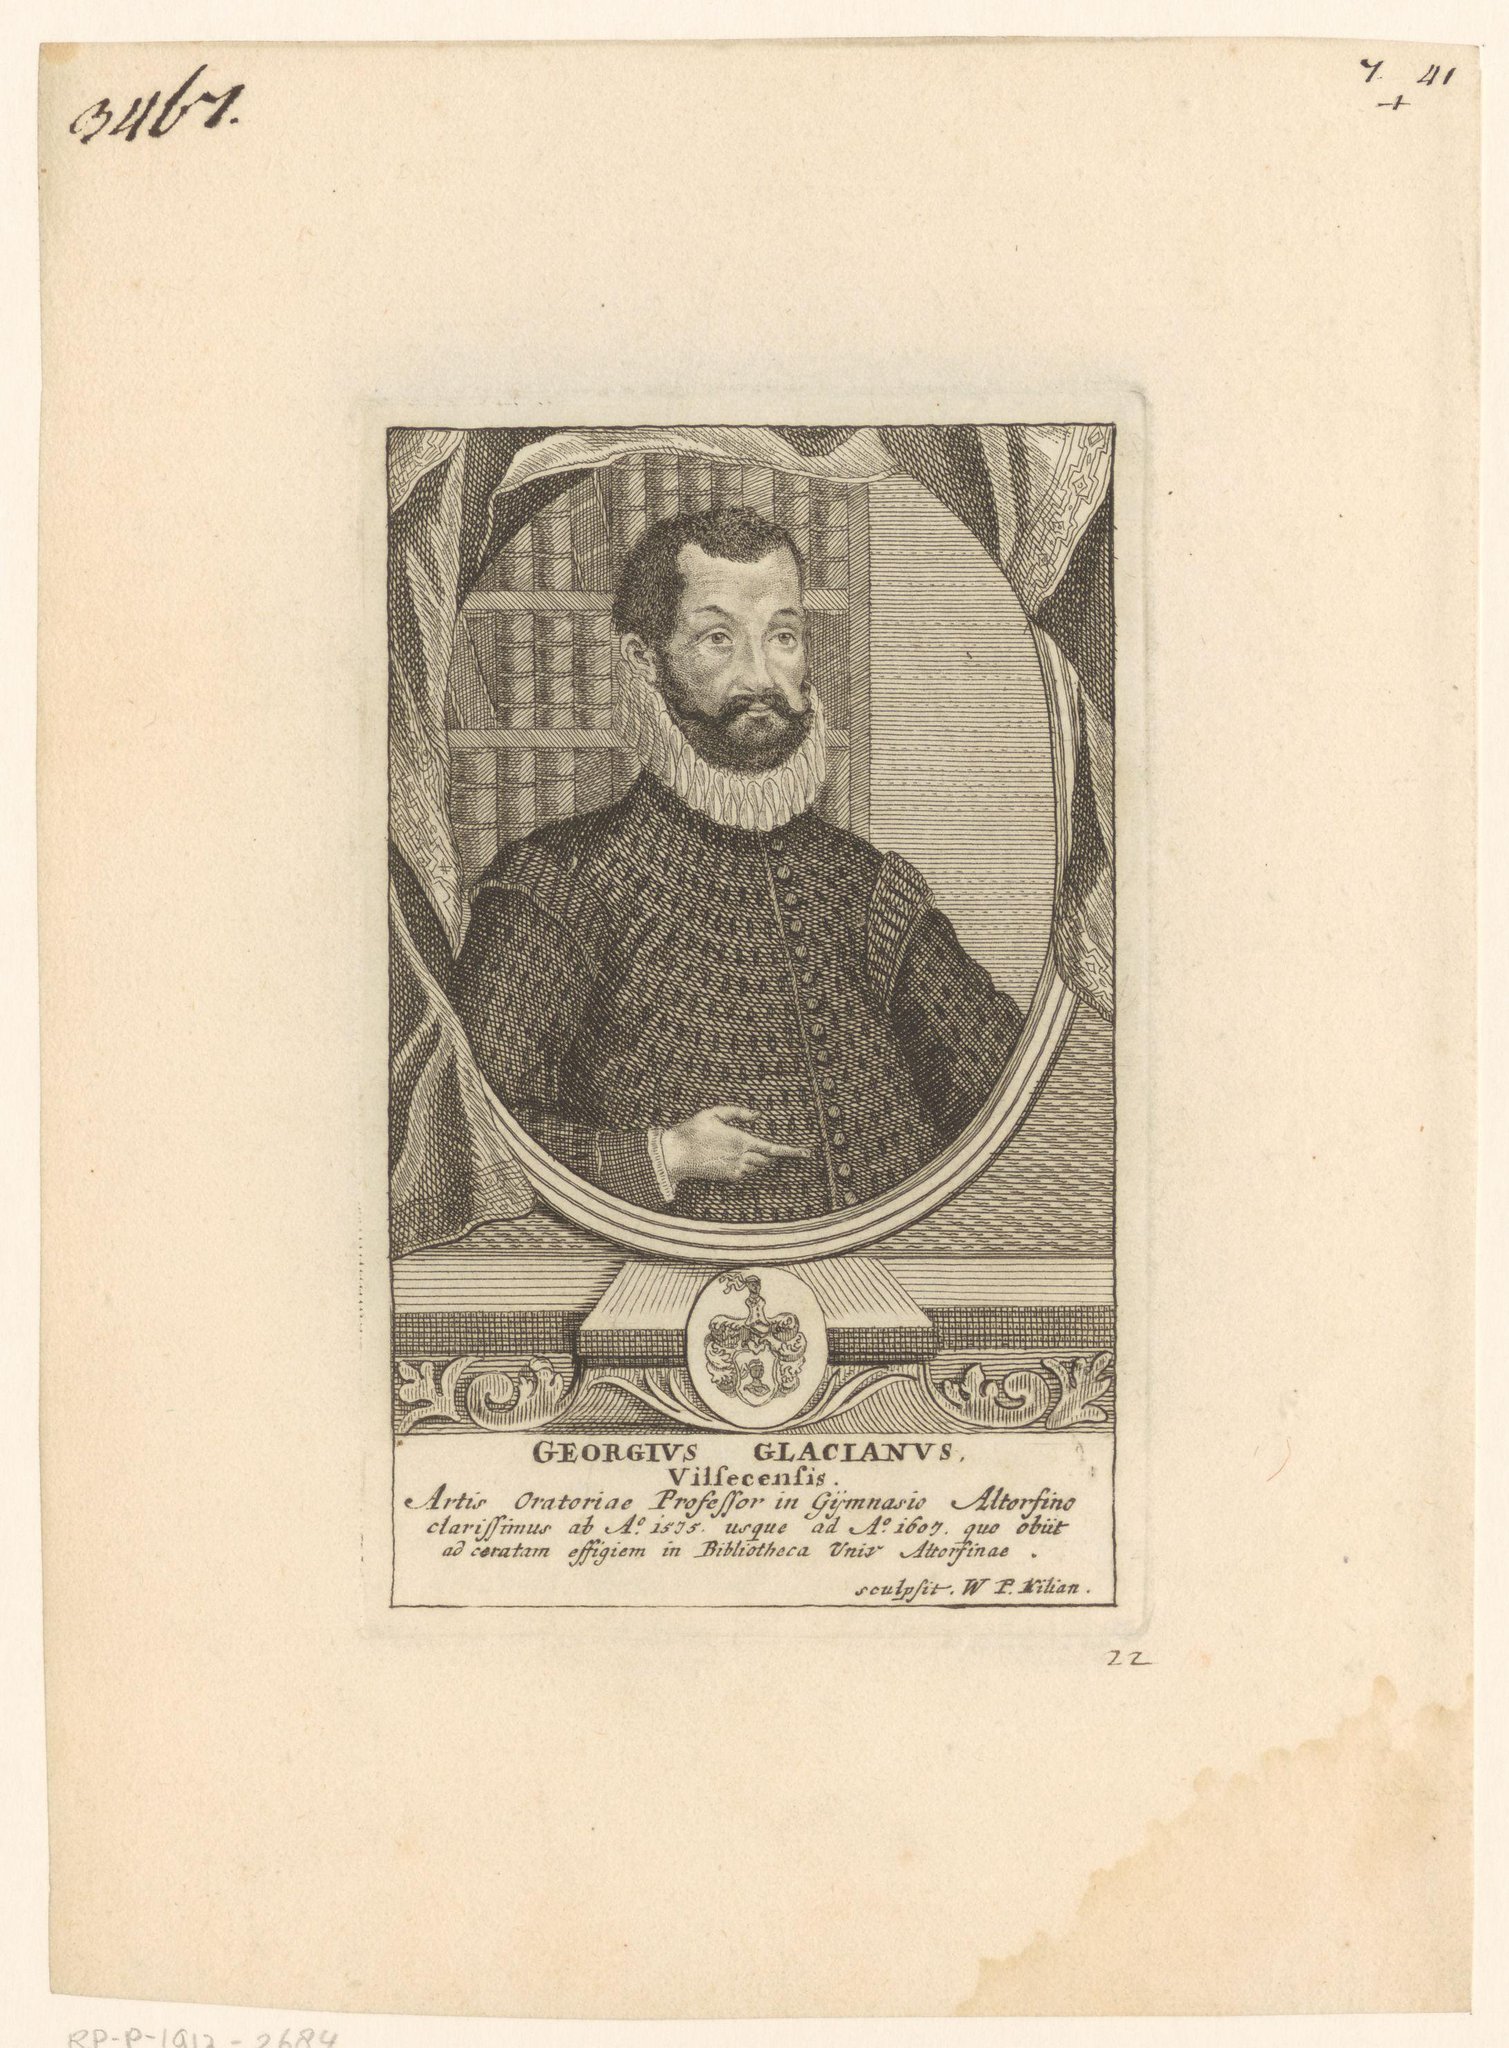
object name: print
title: Portret van Georg Glacianus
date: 1669-1728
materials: paper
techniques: engraving, etching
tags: philology (+ portrait of scholar, scientist), further education (+ portrait of teacher, professor), historical persons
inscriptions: collector's mark: Lugt 2228, number: ‘22’